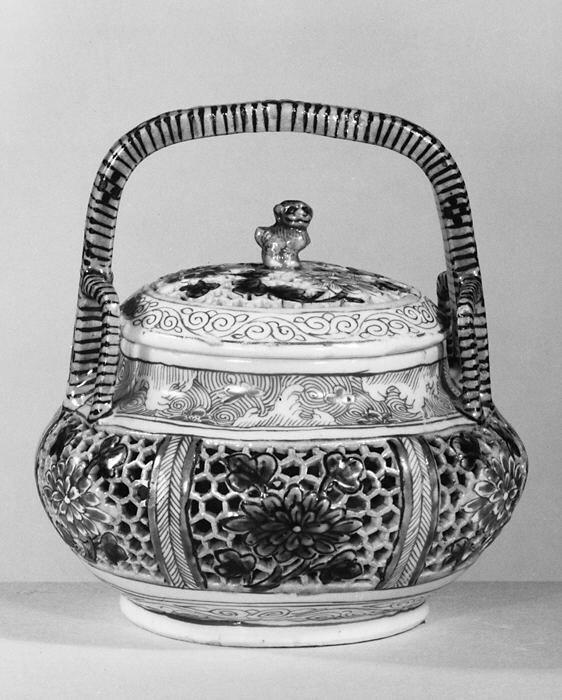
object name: basket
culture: chinese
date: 1662-1722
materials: enamel, porcelain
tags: animals,flowers